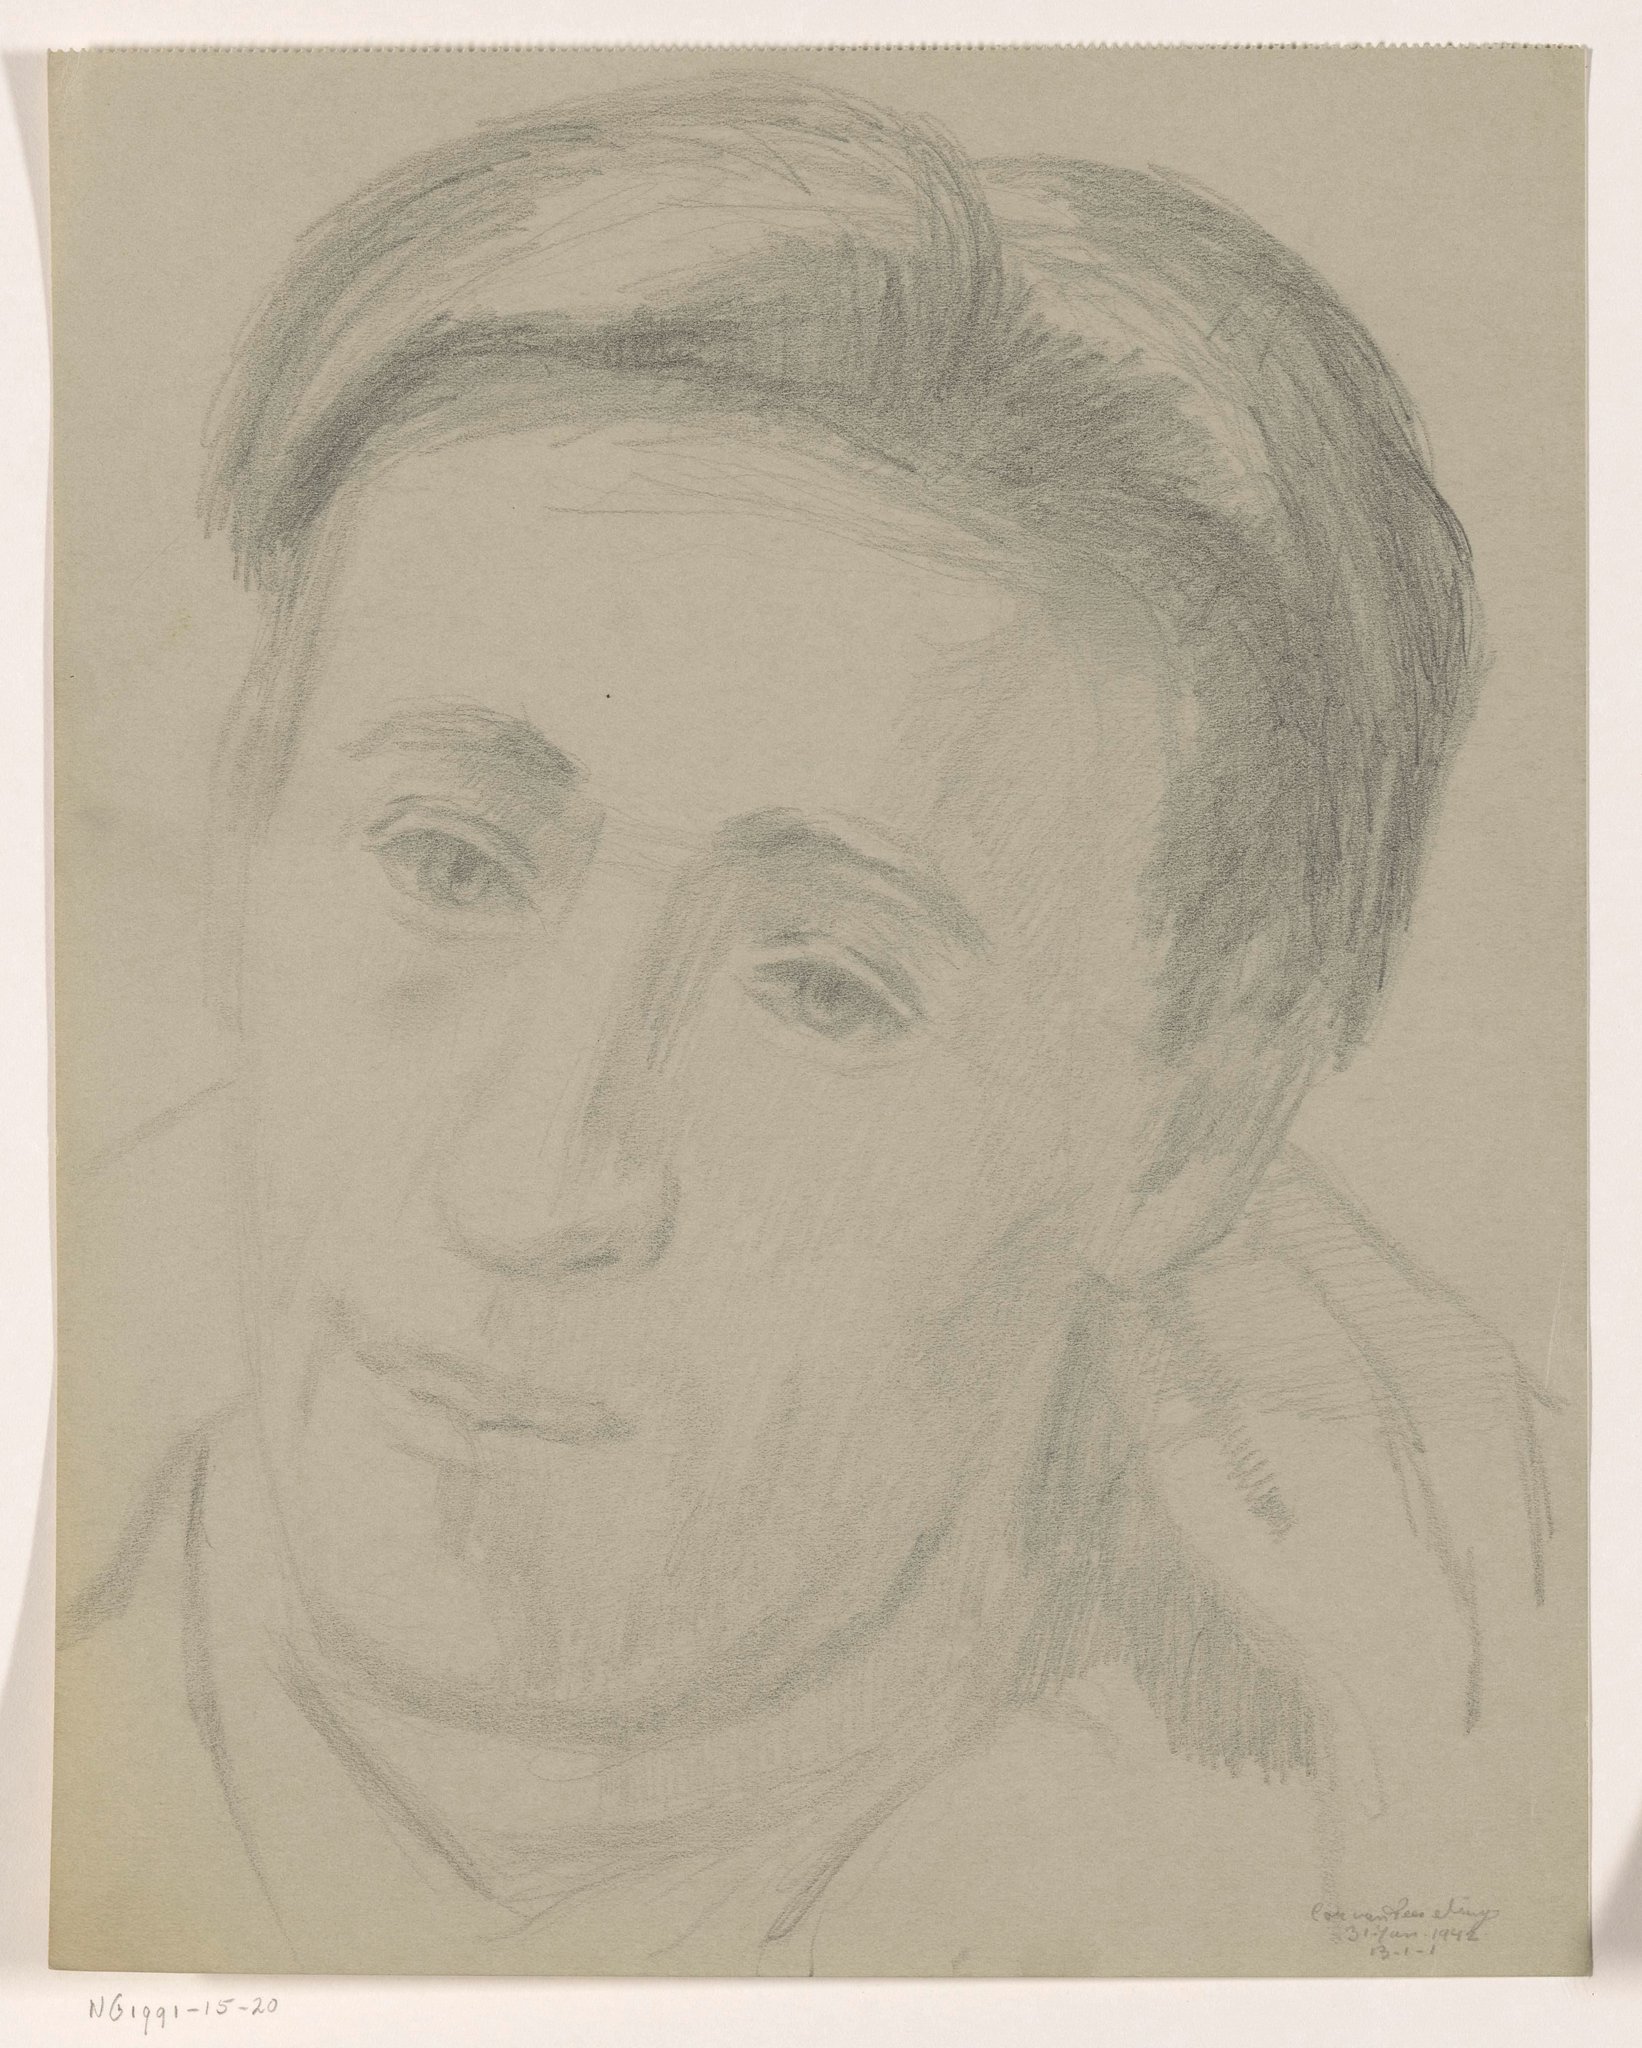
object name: drawing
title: Zelfportretten van Cor van Teeseling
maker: cor van teeseling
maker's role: draughtsman, sculptor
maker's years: 1915-1942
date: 1942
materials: paper, pencil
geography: weteringschans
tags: amsterdam, draughtsman, sculptor, cor van teeseling, historical persons, prisoner in cell or locked place, portrait, self-portrait of draughtsman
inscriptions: signature and date: ‘31 Jan 1942 / C. van Teeseling / B-1-1’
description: Zelfportret van Cor van Teeseling: B-1-1, 31 januari. Getekend zelfportret van Cor van Teeseling met zijn hoofd naar links gewend in de gevangenis aan Weteringschans, cel B-1-1.